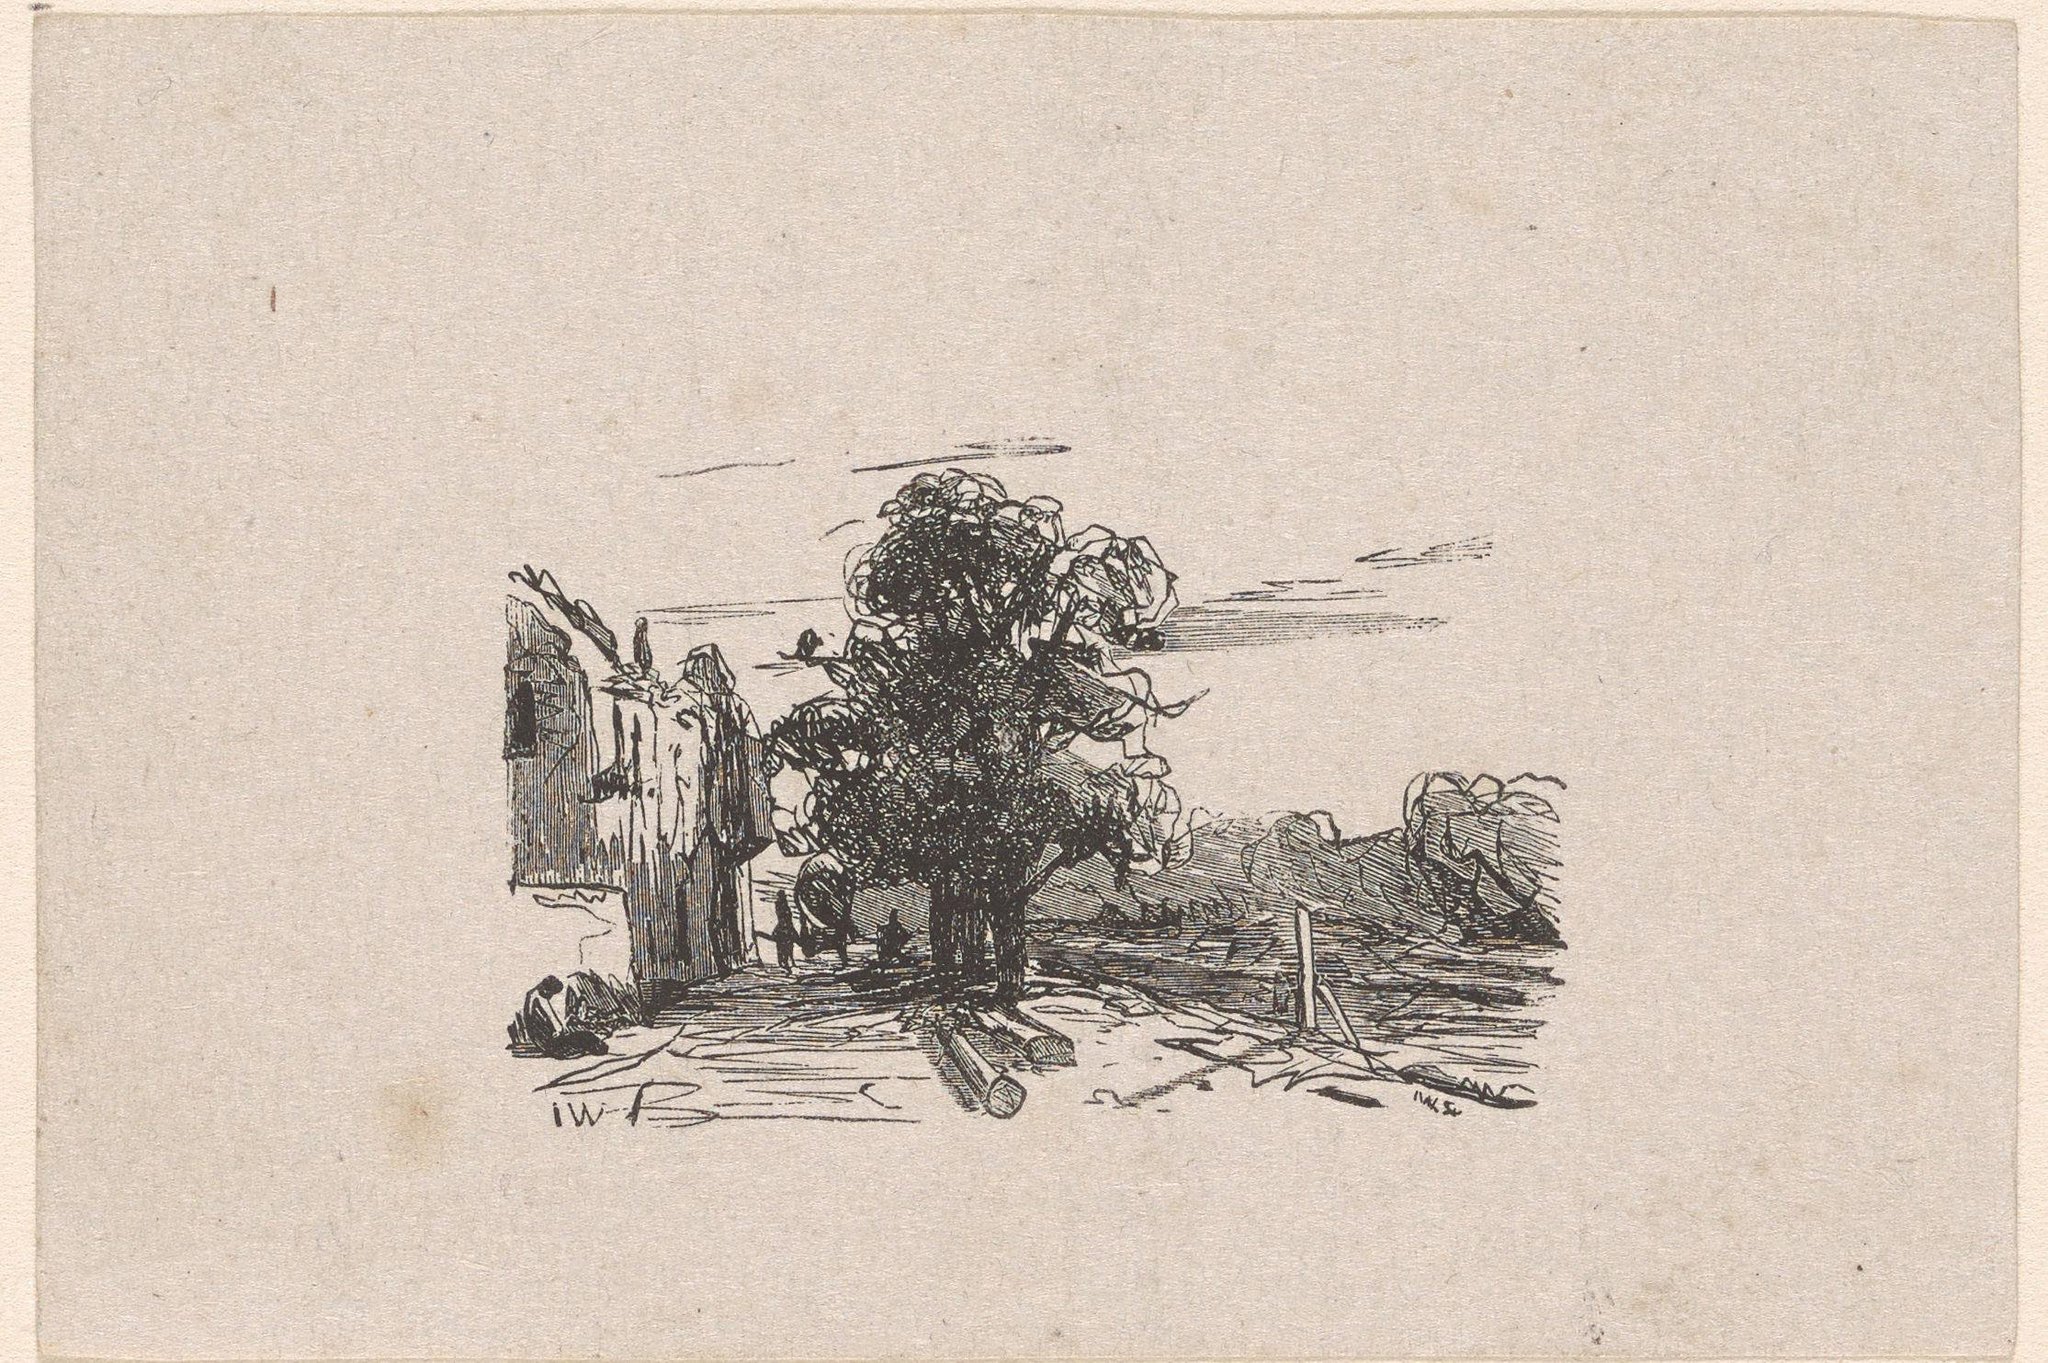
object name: print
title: Landschap met een bomenrij en huizen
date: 1836-1912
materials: paper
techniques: engraving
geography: netherlands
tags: city-view, and landscape with man-made constructions, trees